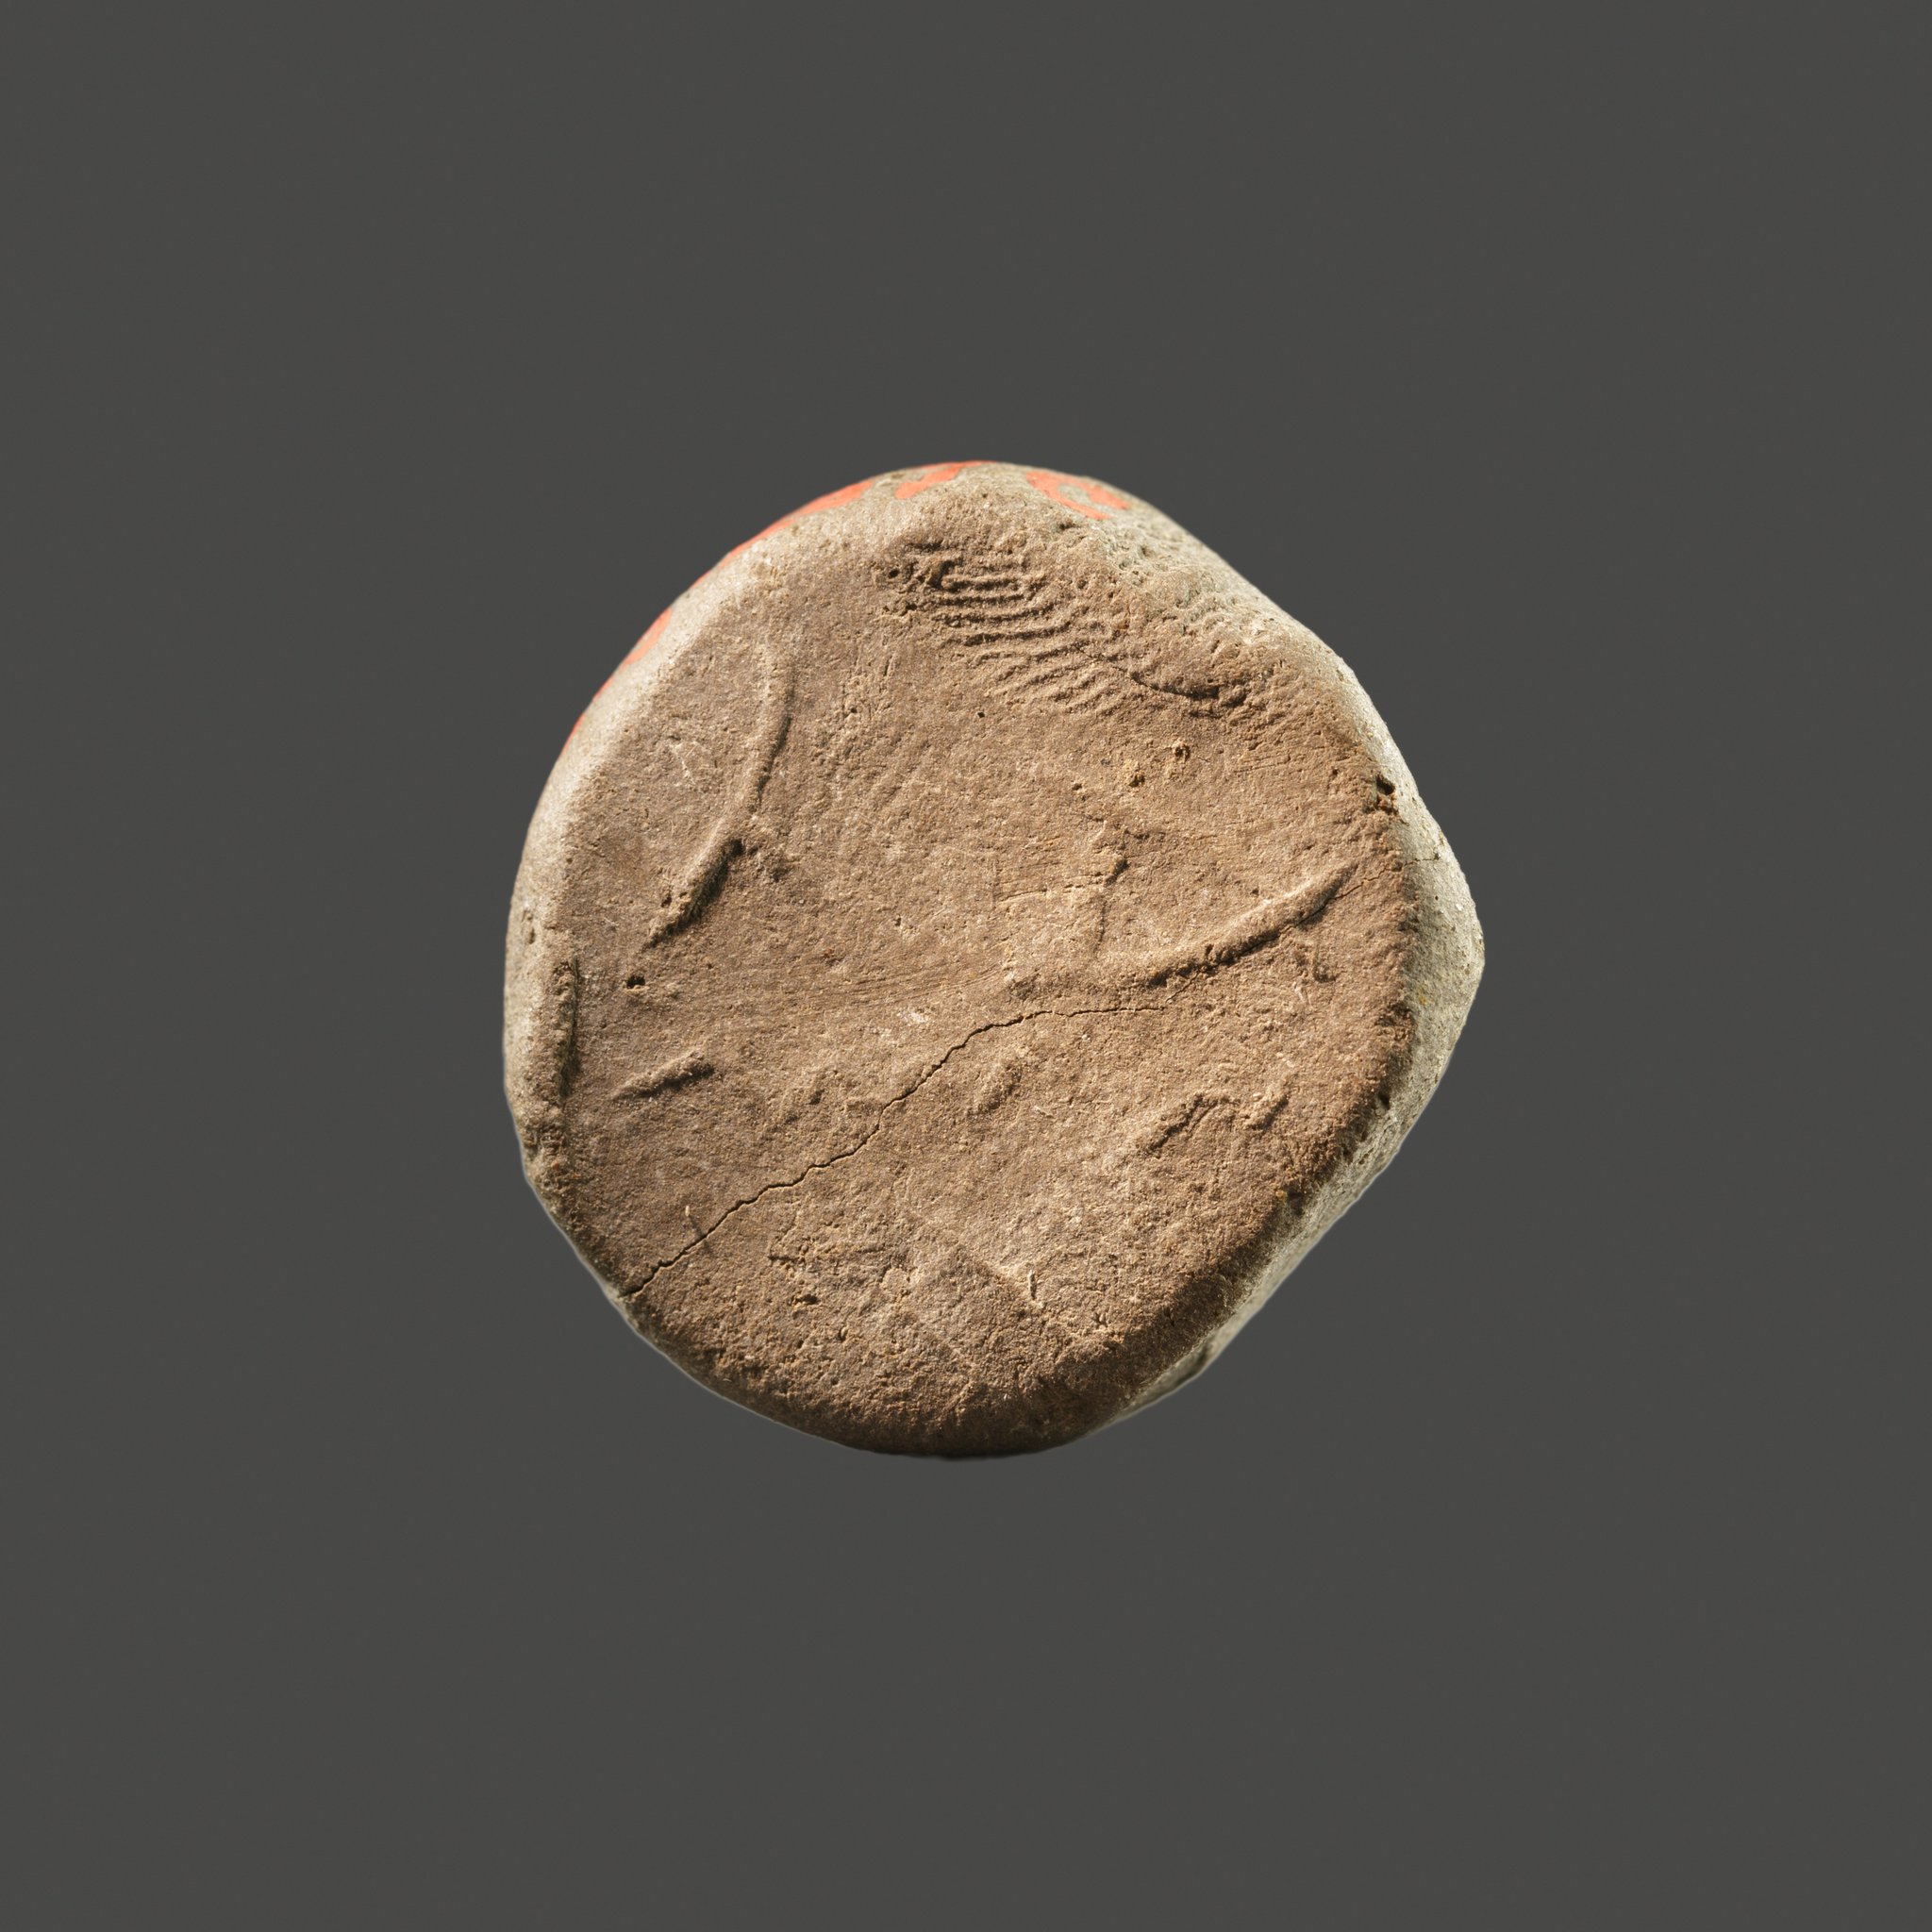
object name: reference sealing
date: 1961-1954 BCE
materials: mud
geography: egypt